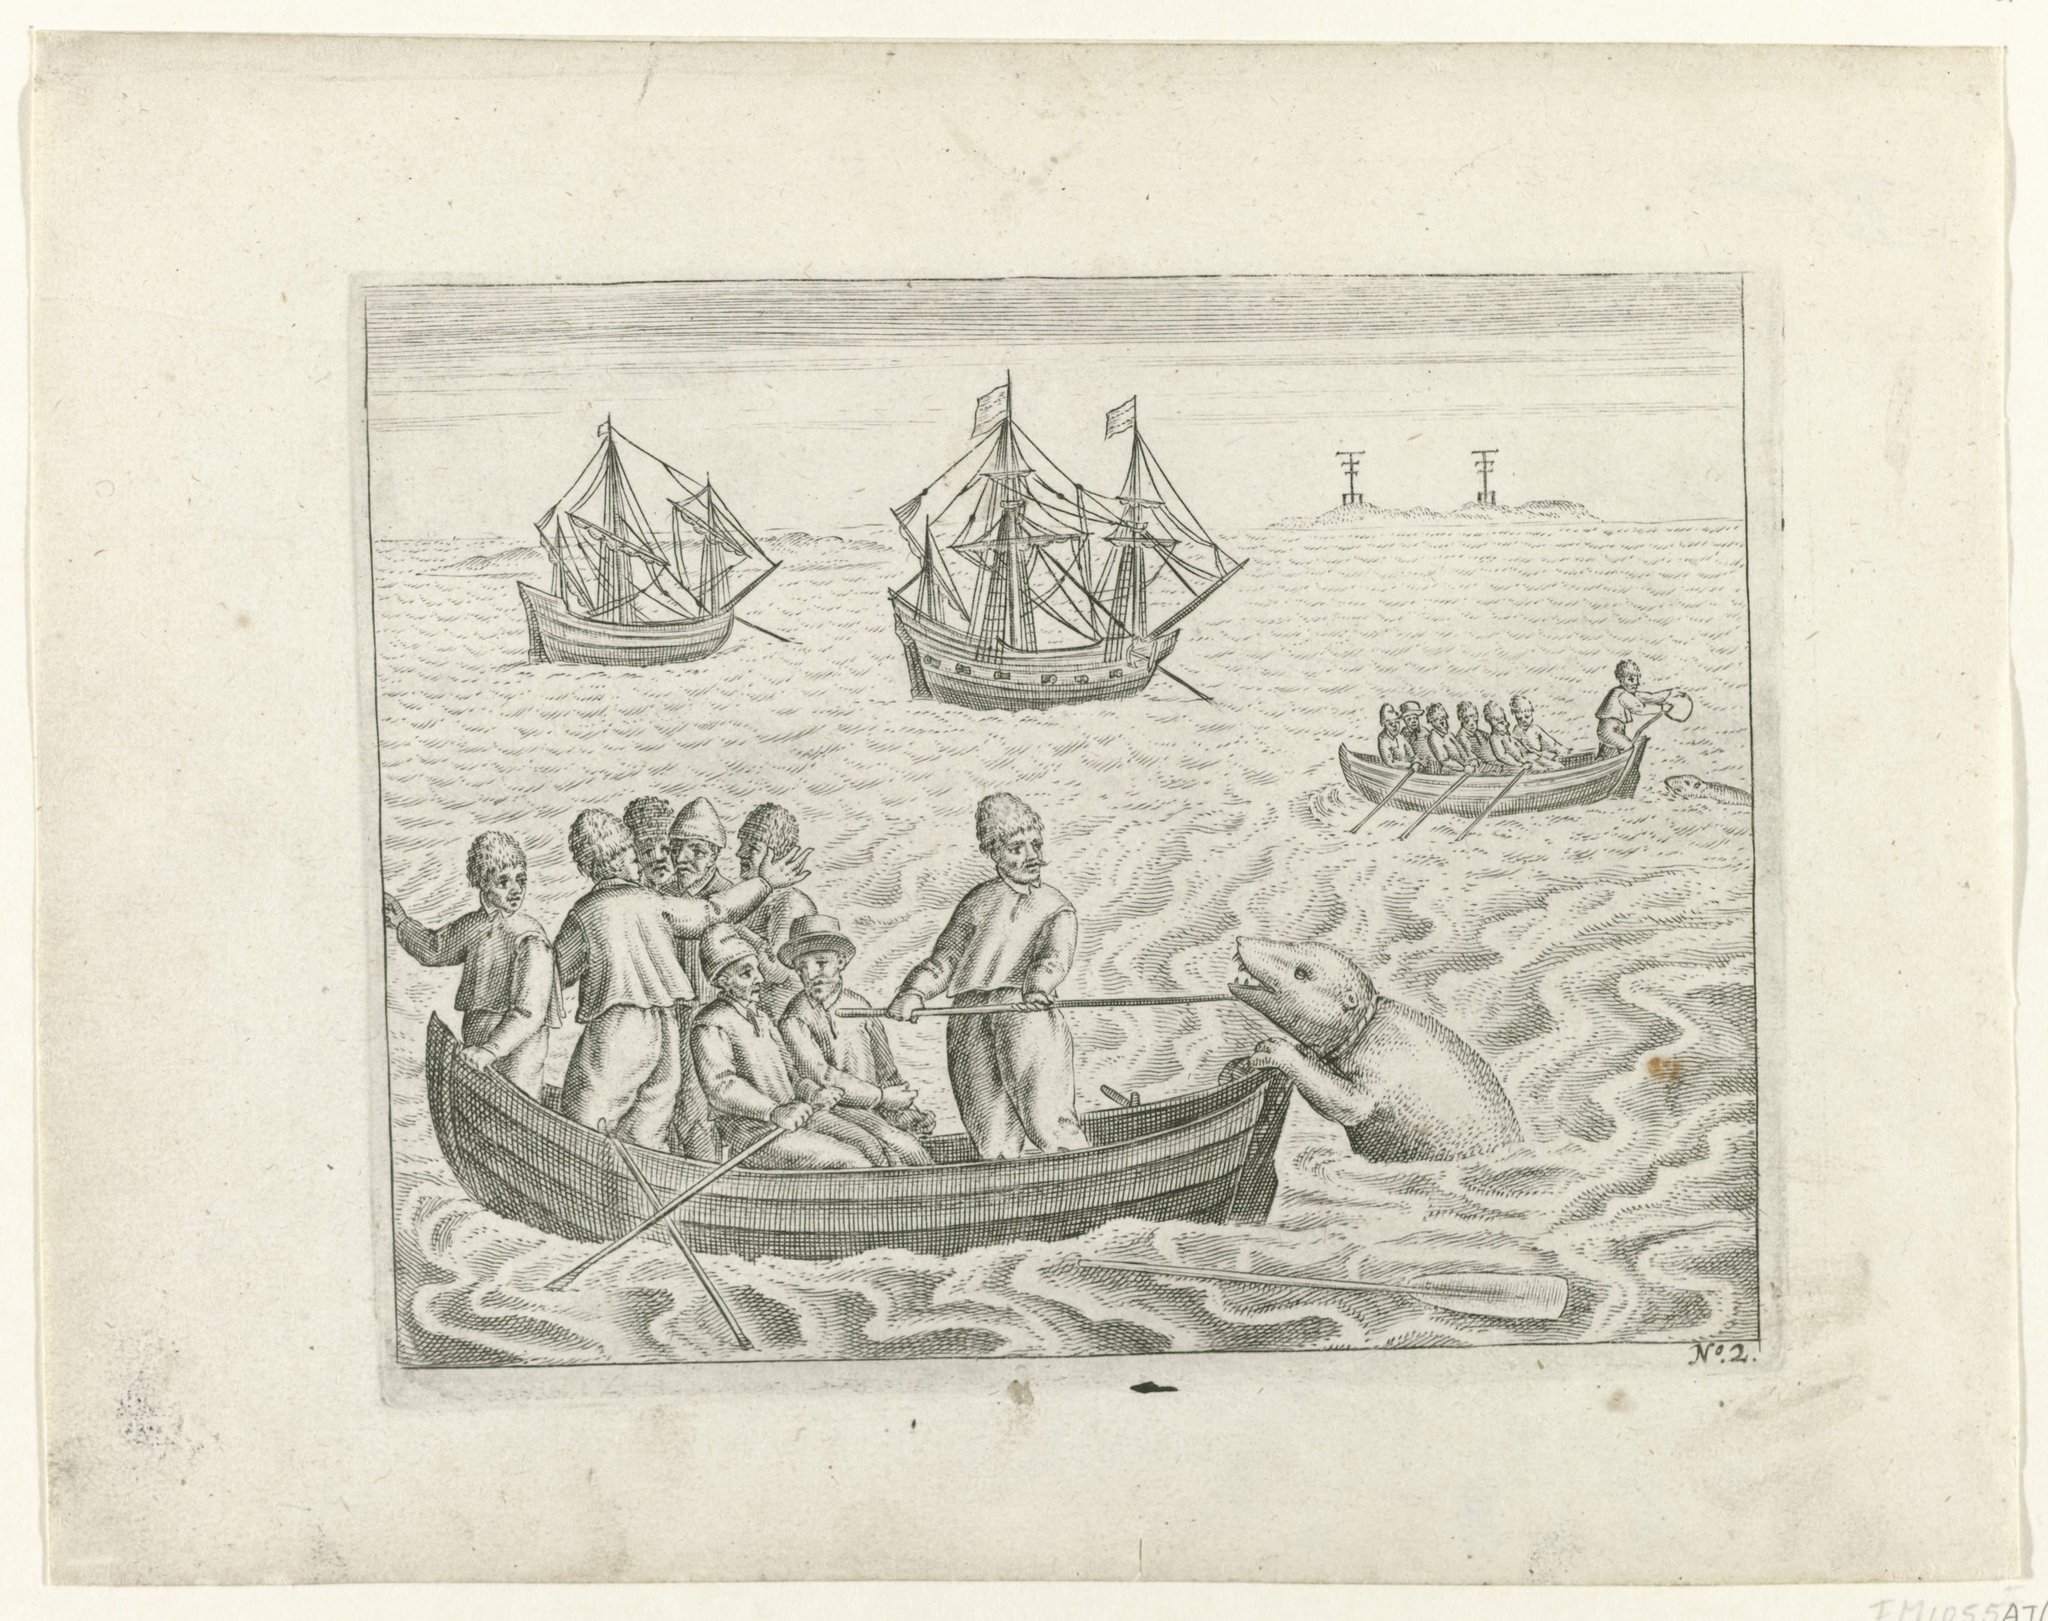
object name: history print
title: Het vangen van een ijsbeer, 1594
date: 1615-1617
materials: paper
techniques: engraving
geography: northern netherlands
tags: willem barendsz., amsterdam, jacob van heemskerck, beasts of prey, predatory animals: polar bear, landscapes in polar regions, exploration, expedition, voyage of discovery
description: Gebruikt als illustratie eerst in: G. de Veer, De waerachtige beschrijvinge vande drie seylagien, drie jaren achter mal-kanderen deur de Hollandtsche ende Zeelandtsche Schepen, by noorden Noorweghen, Moscovien ende tartarien nae de Coninckrijcken van Catthay ende China ghedaene, [Michiel Colijn, Amsterdam 1617]. Later gebruikt in: Kort verhael van d'eerste Schipvaerd der Hollandsche ende Zeeusche Schepen by noorden Noorwegen, Moscovien ende Tartarien om, nae de Coningrijcken van Cathay ende China, getogen uyt het Journael van Gerrit de Veer. Opgenomen in: I. Commelin, Begin ende voortgangh, van de Vereenighde Nederlantsche Geoctroyeerde Oost-Indische Compagnie, J. Janssonius, Amsterdam 1646. Genummerd: No. 2.